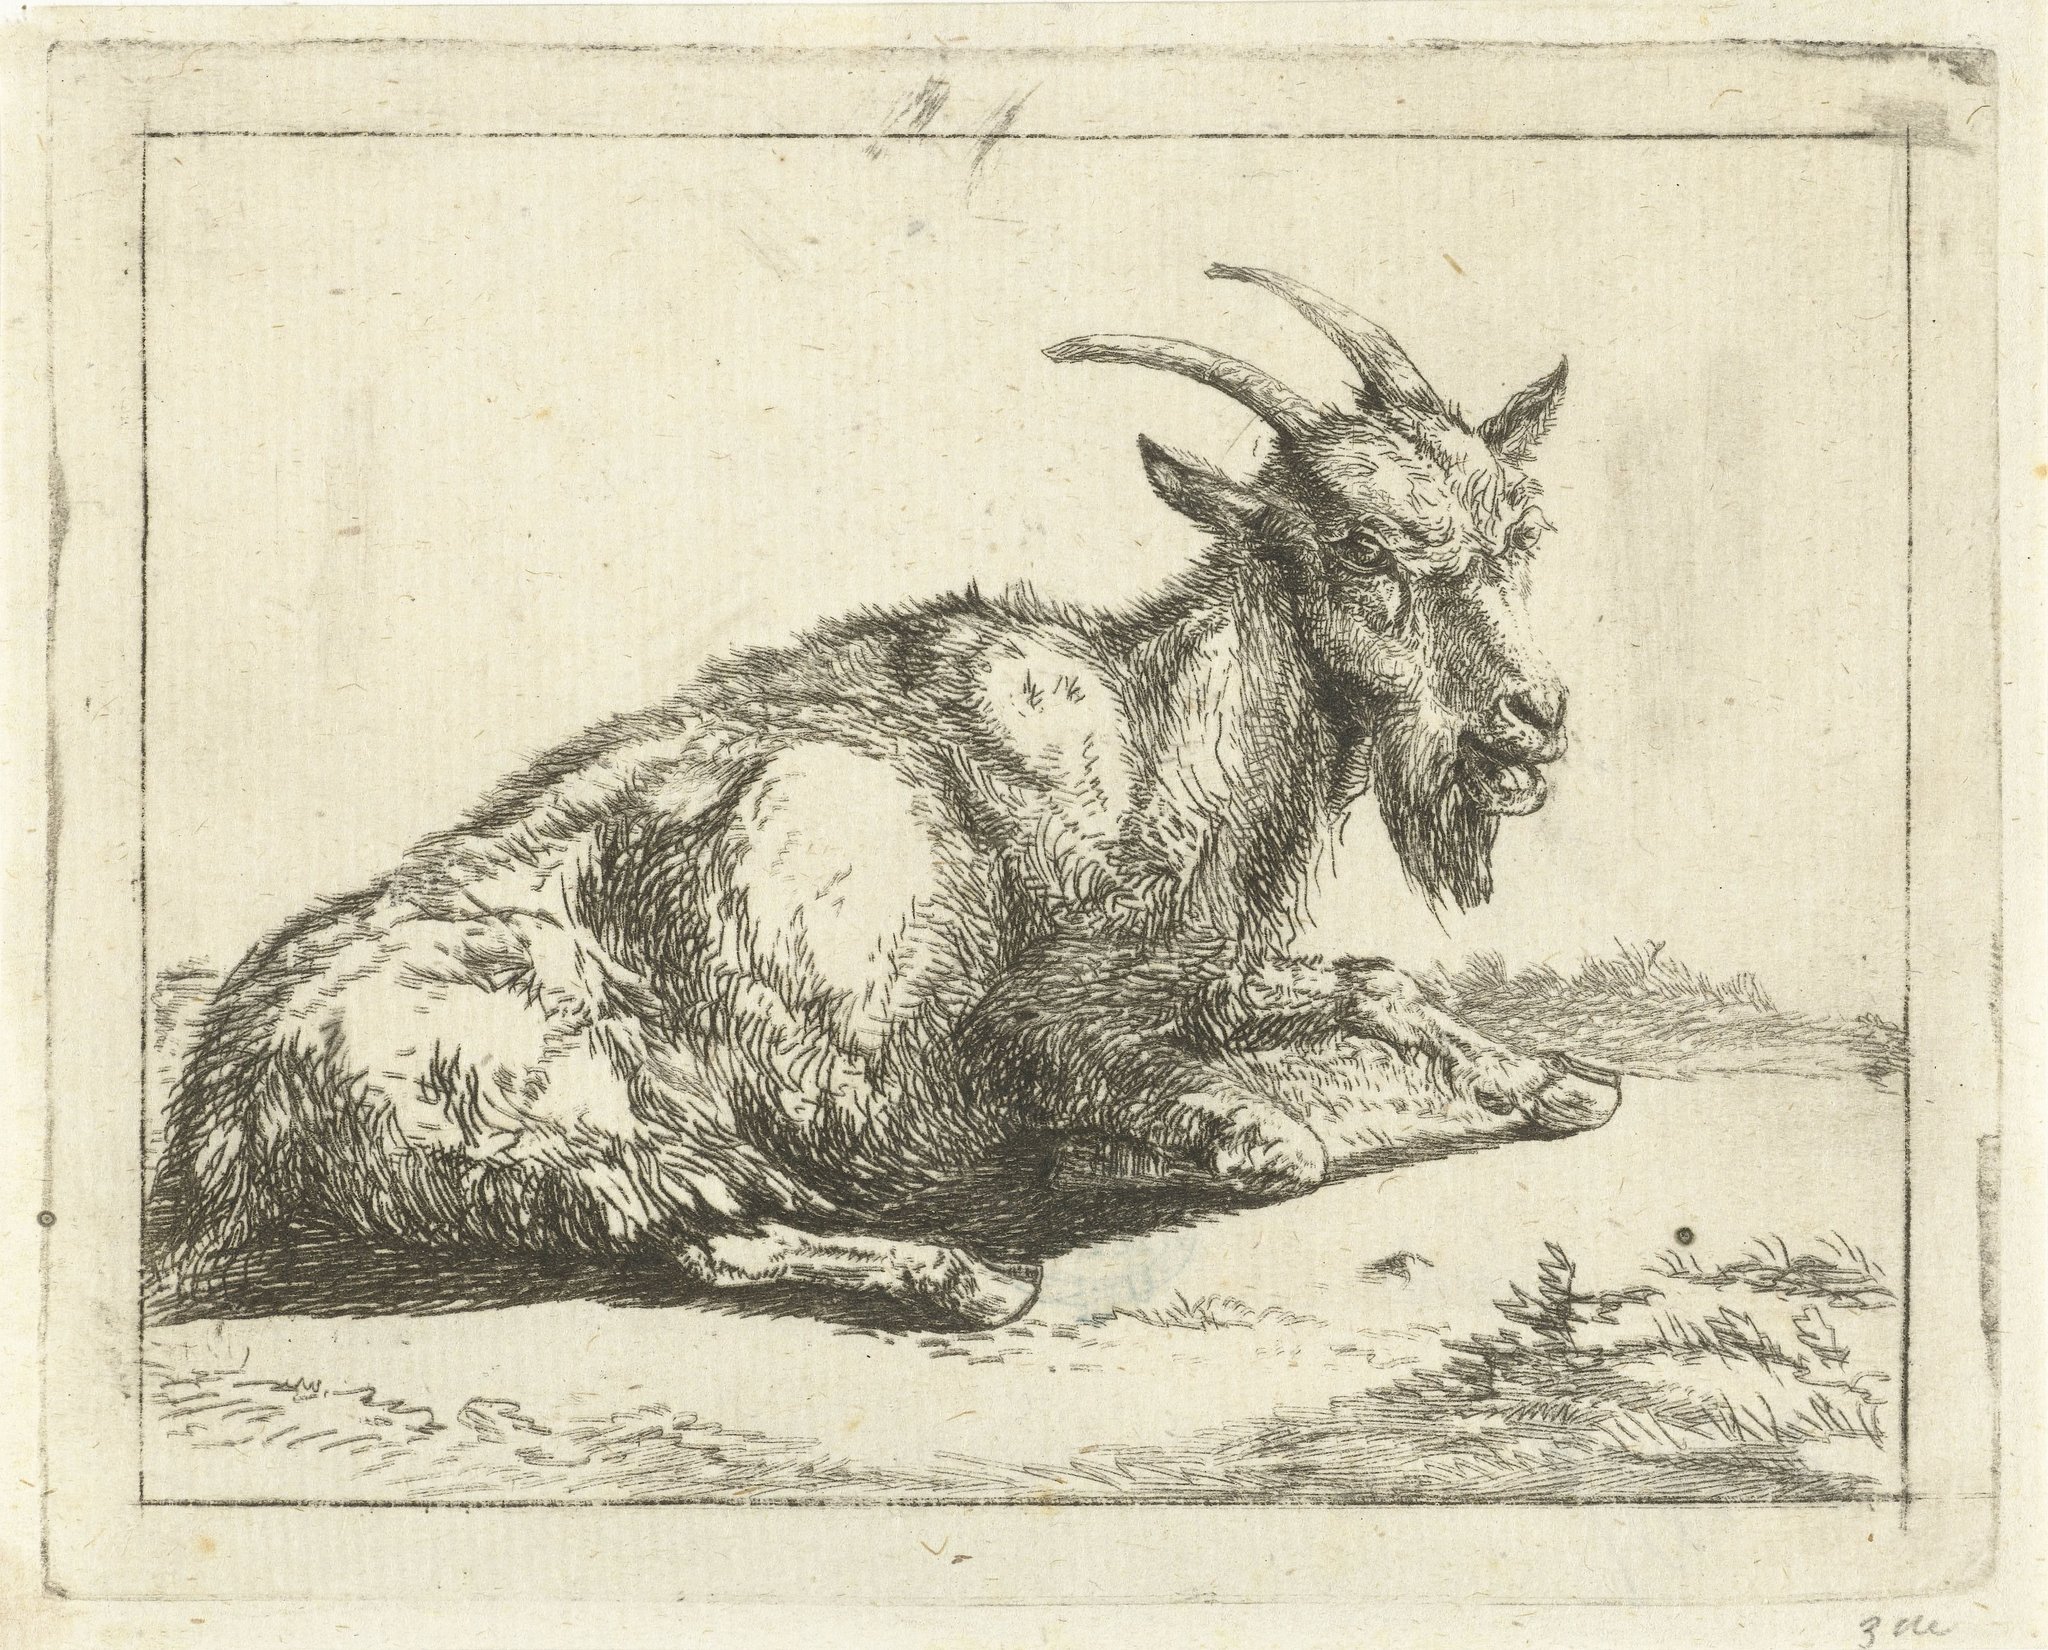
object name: print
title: Geit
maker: jan dasveldt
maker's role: draughtsman, print maker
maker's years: 1770-1855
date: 1780-1855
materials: paper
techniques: etching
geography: amsterdam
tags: goat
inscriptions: collector's mark: Lugt 2228, collector's mark: Lugt 1962